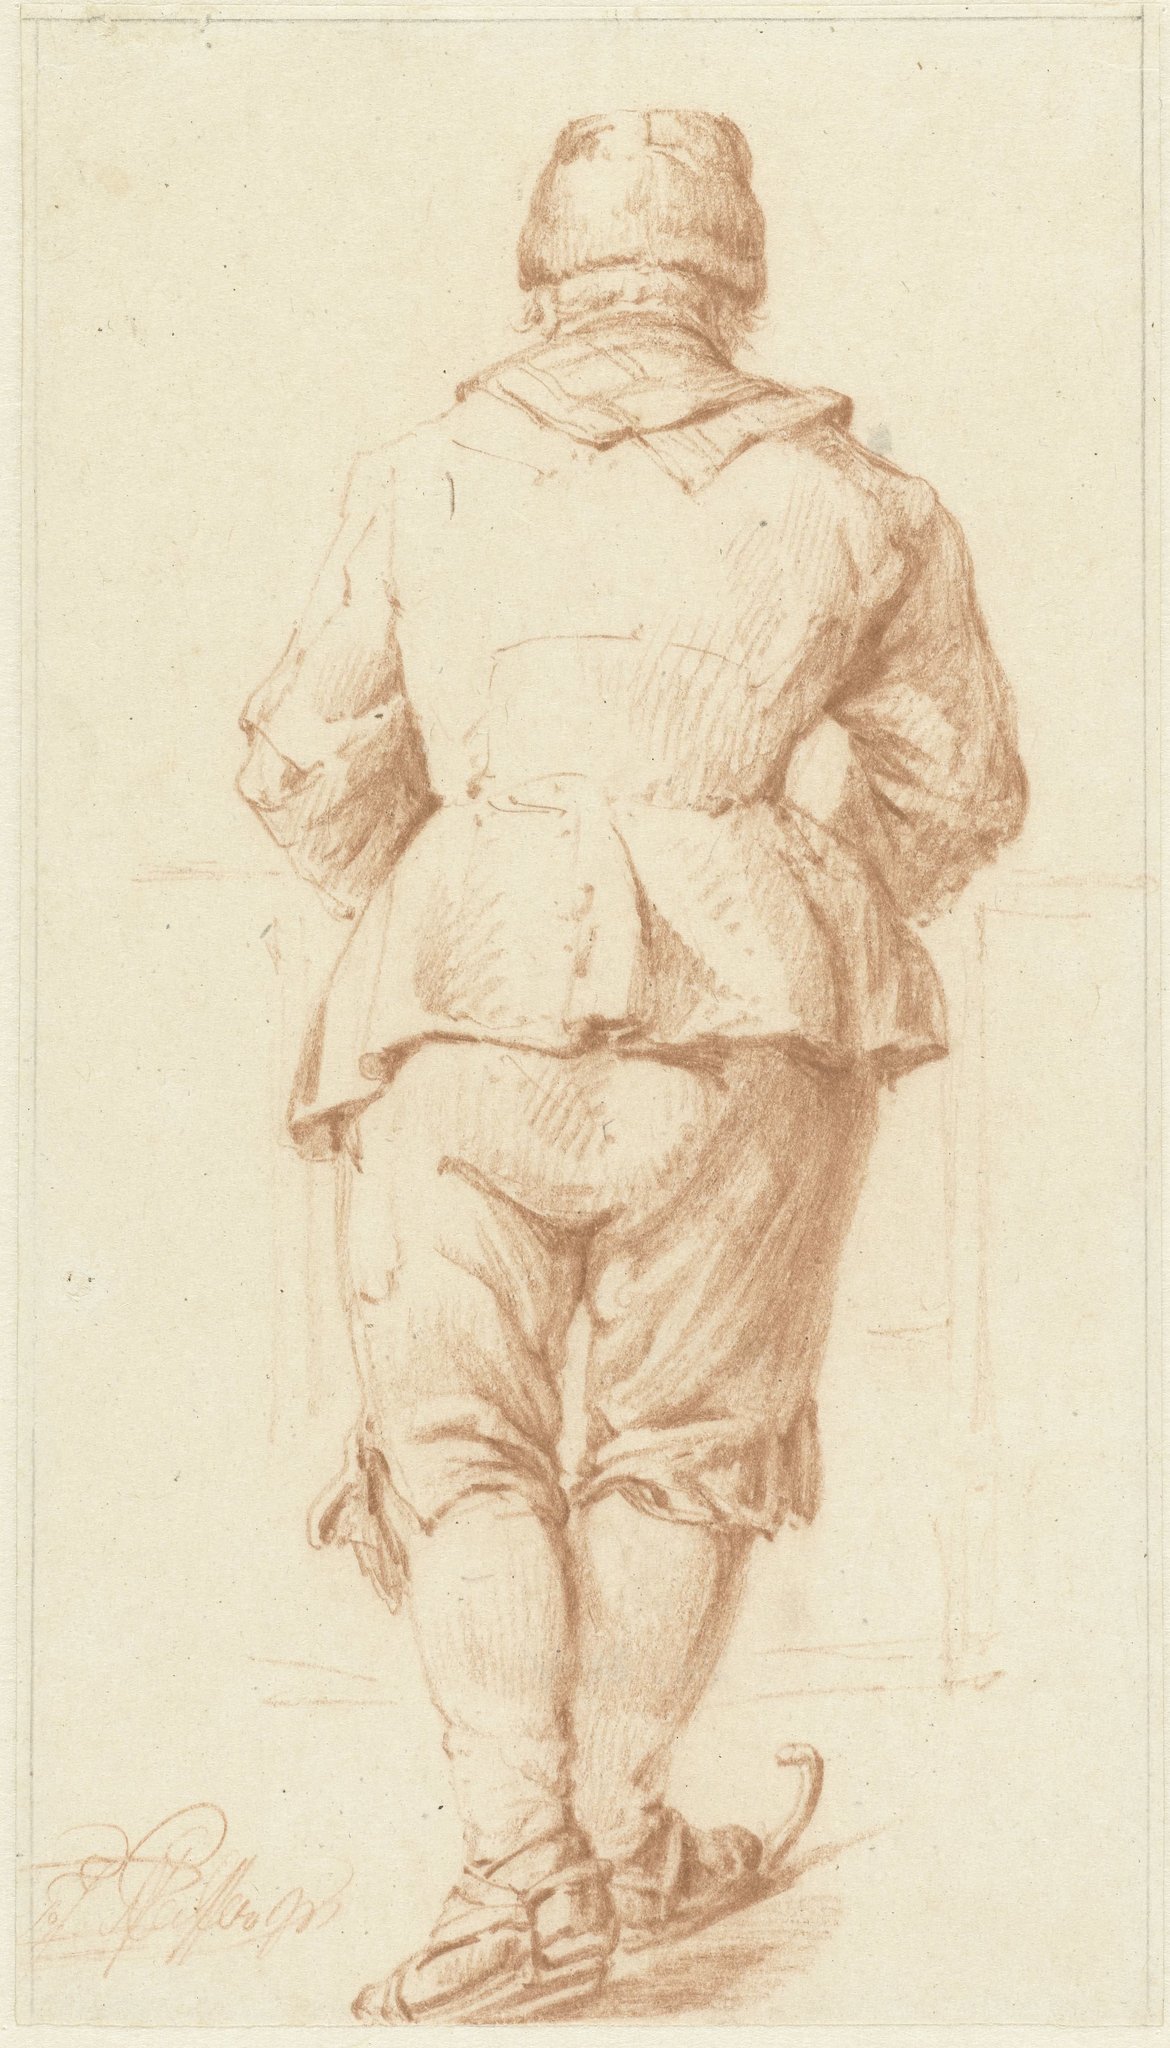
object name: drawing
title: Schaatsende jongen op de rug gezien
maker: françois joseph pfeiffer (ii)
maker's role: draughtsman, print maker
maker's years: 1778-1835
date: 1788-1835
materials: chalk, paper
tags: skates (winter sports)